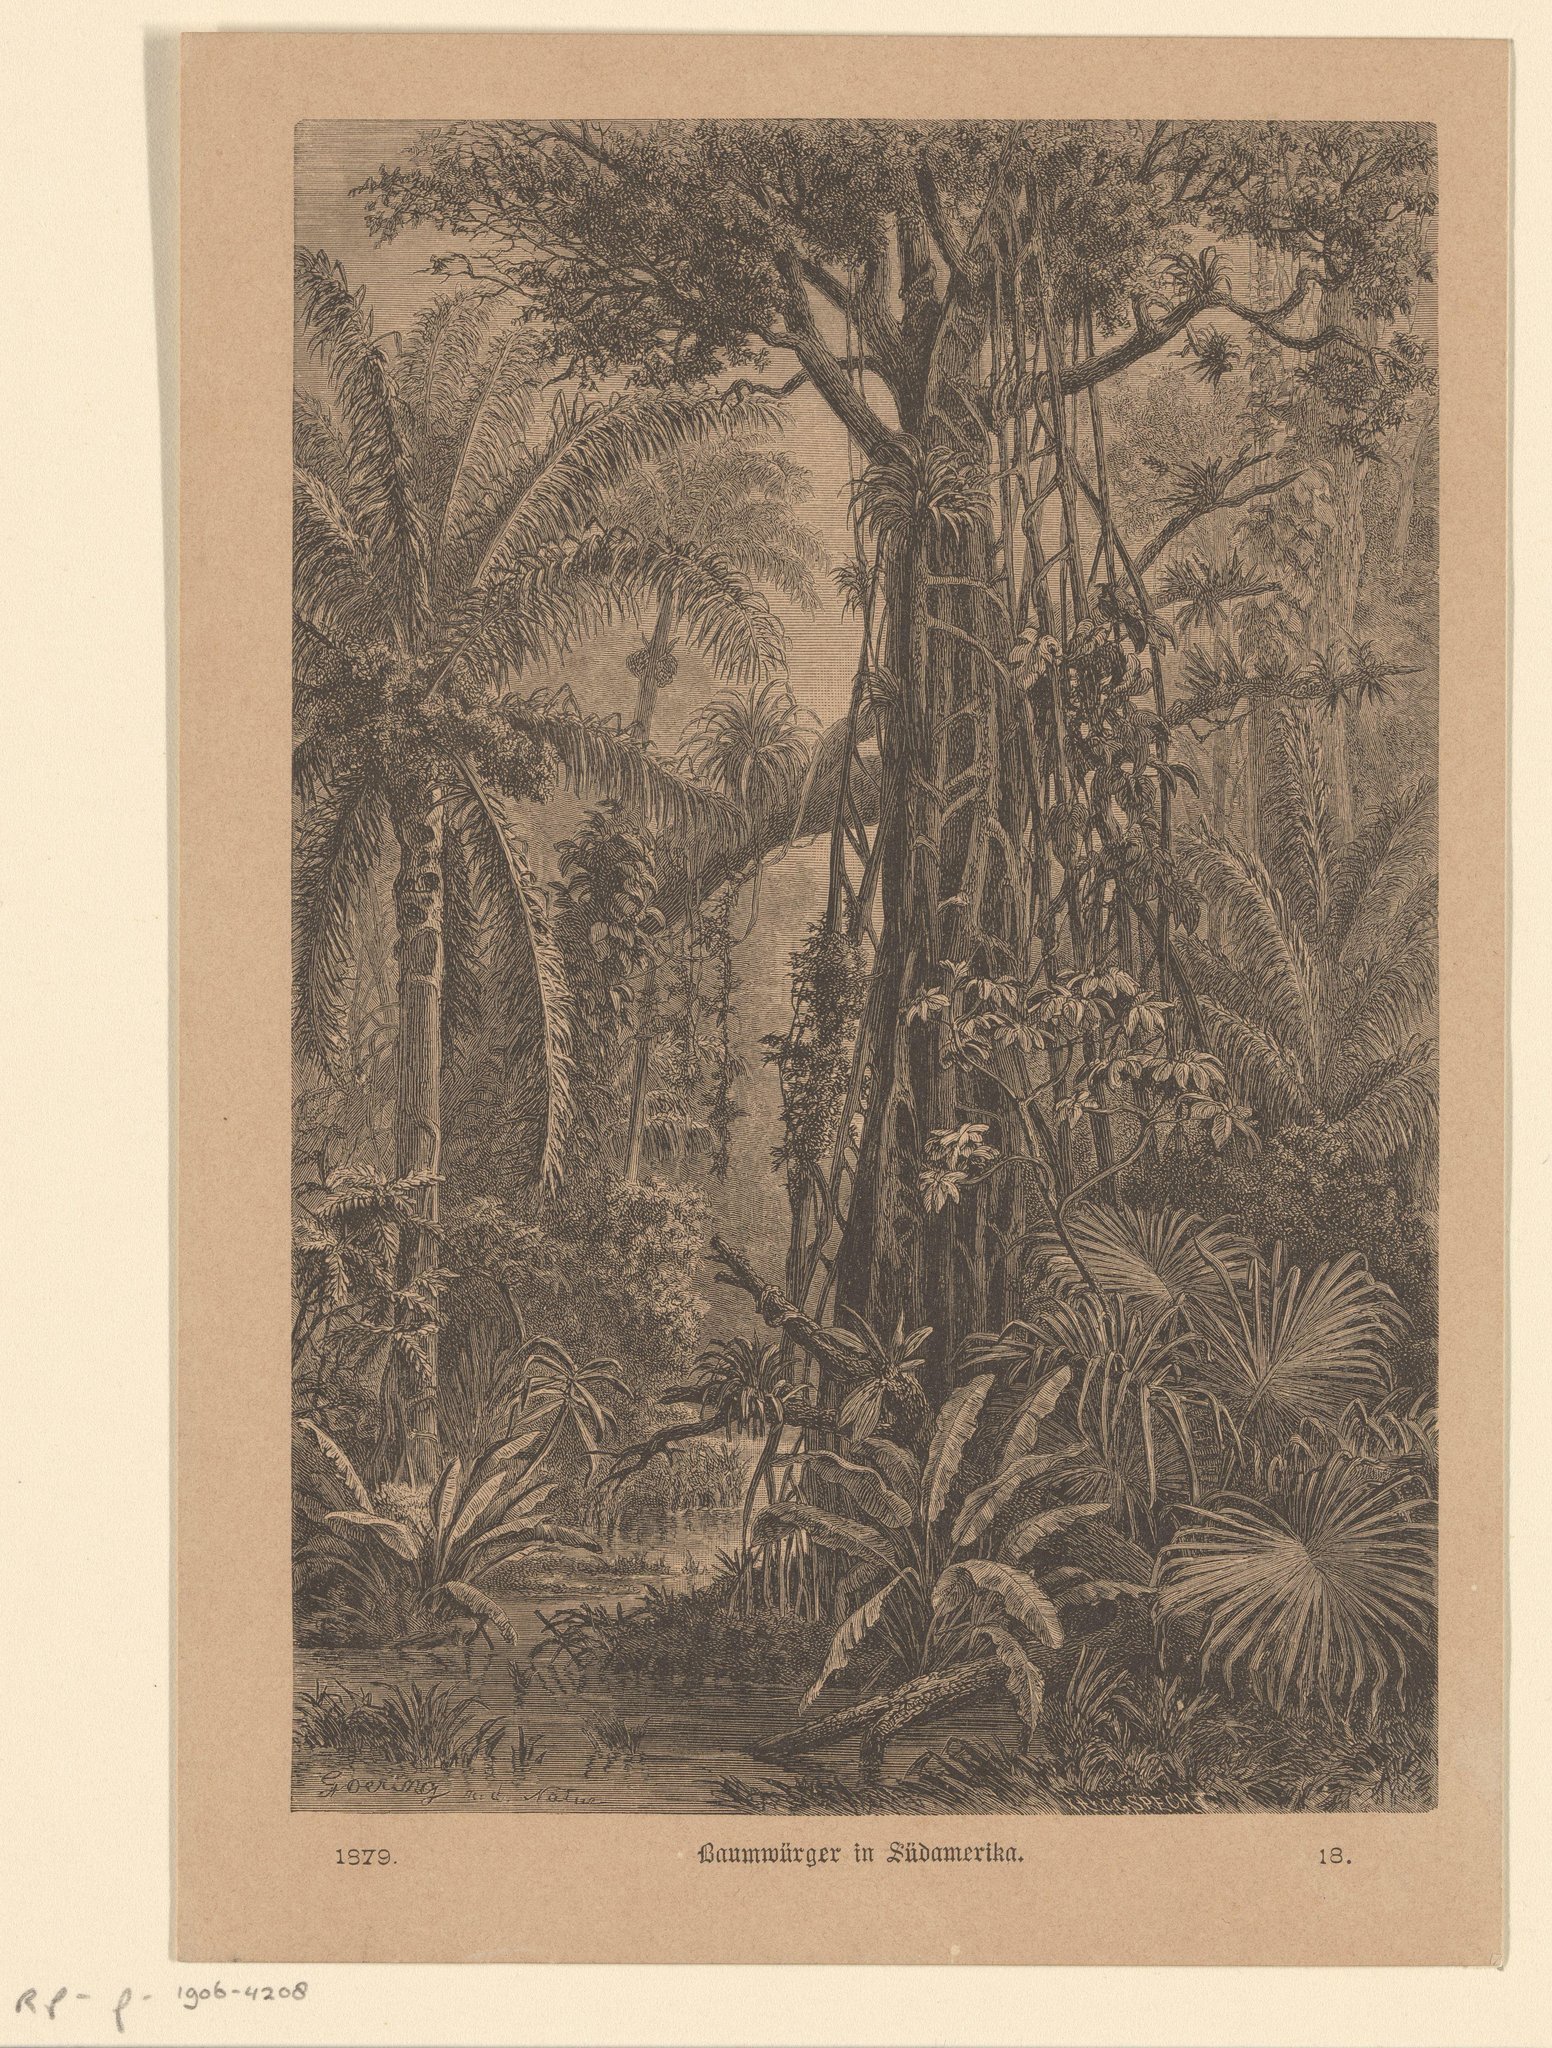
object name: print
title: Bosgezicht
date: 1879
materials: paper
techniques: engraving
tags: jungle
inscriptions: collector's mark: Lugt 2228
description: Bomen en lianen in het regenwoud van Zuid-Amerika.